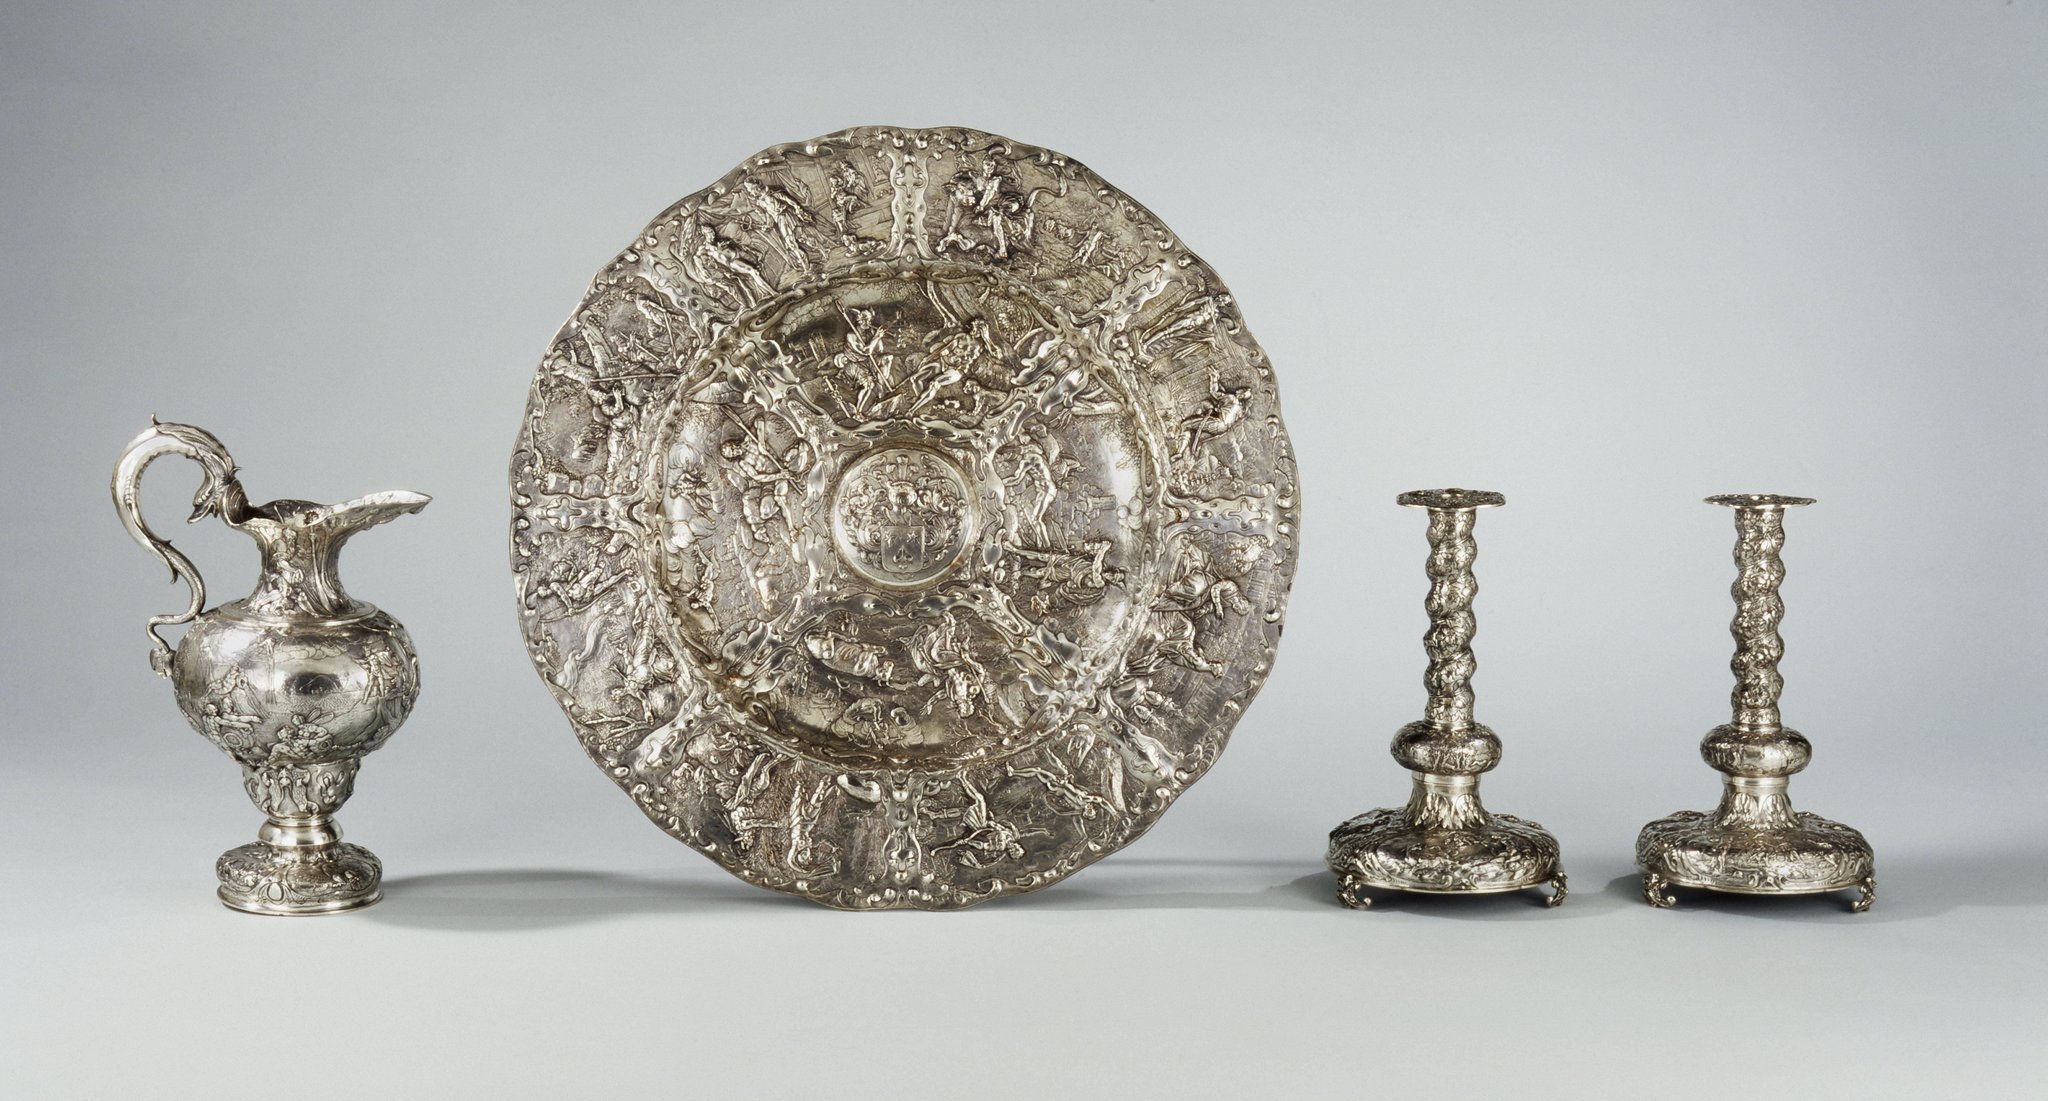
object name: ewer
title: Galvanoplastische reproductie van een kan met voorstellingen van de vier elementen uit de Popta-schat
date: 1881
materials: copper, silver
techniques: galvanoplasty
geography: london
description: Galvanoplastische reproductie van een kan. Op de basis gedreven voorstellingen van de vier elementen; op de buik Neptunus omringd door zeegoden. Het handvat heeft de vorm van een slang.